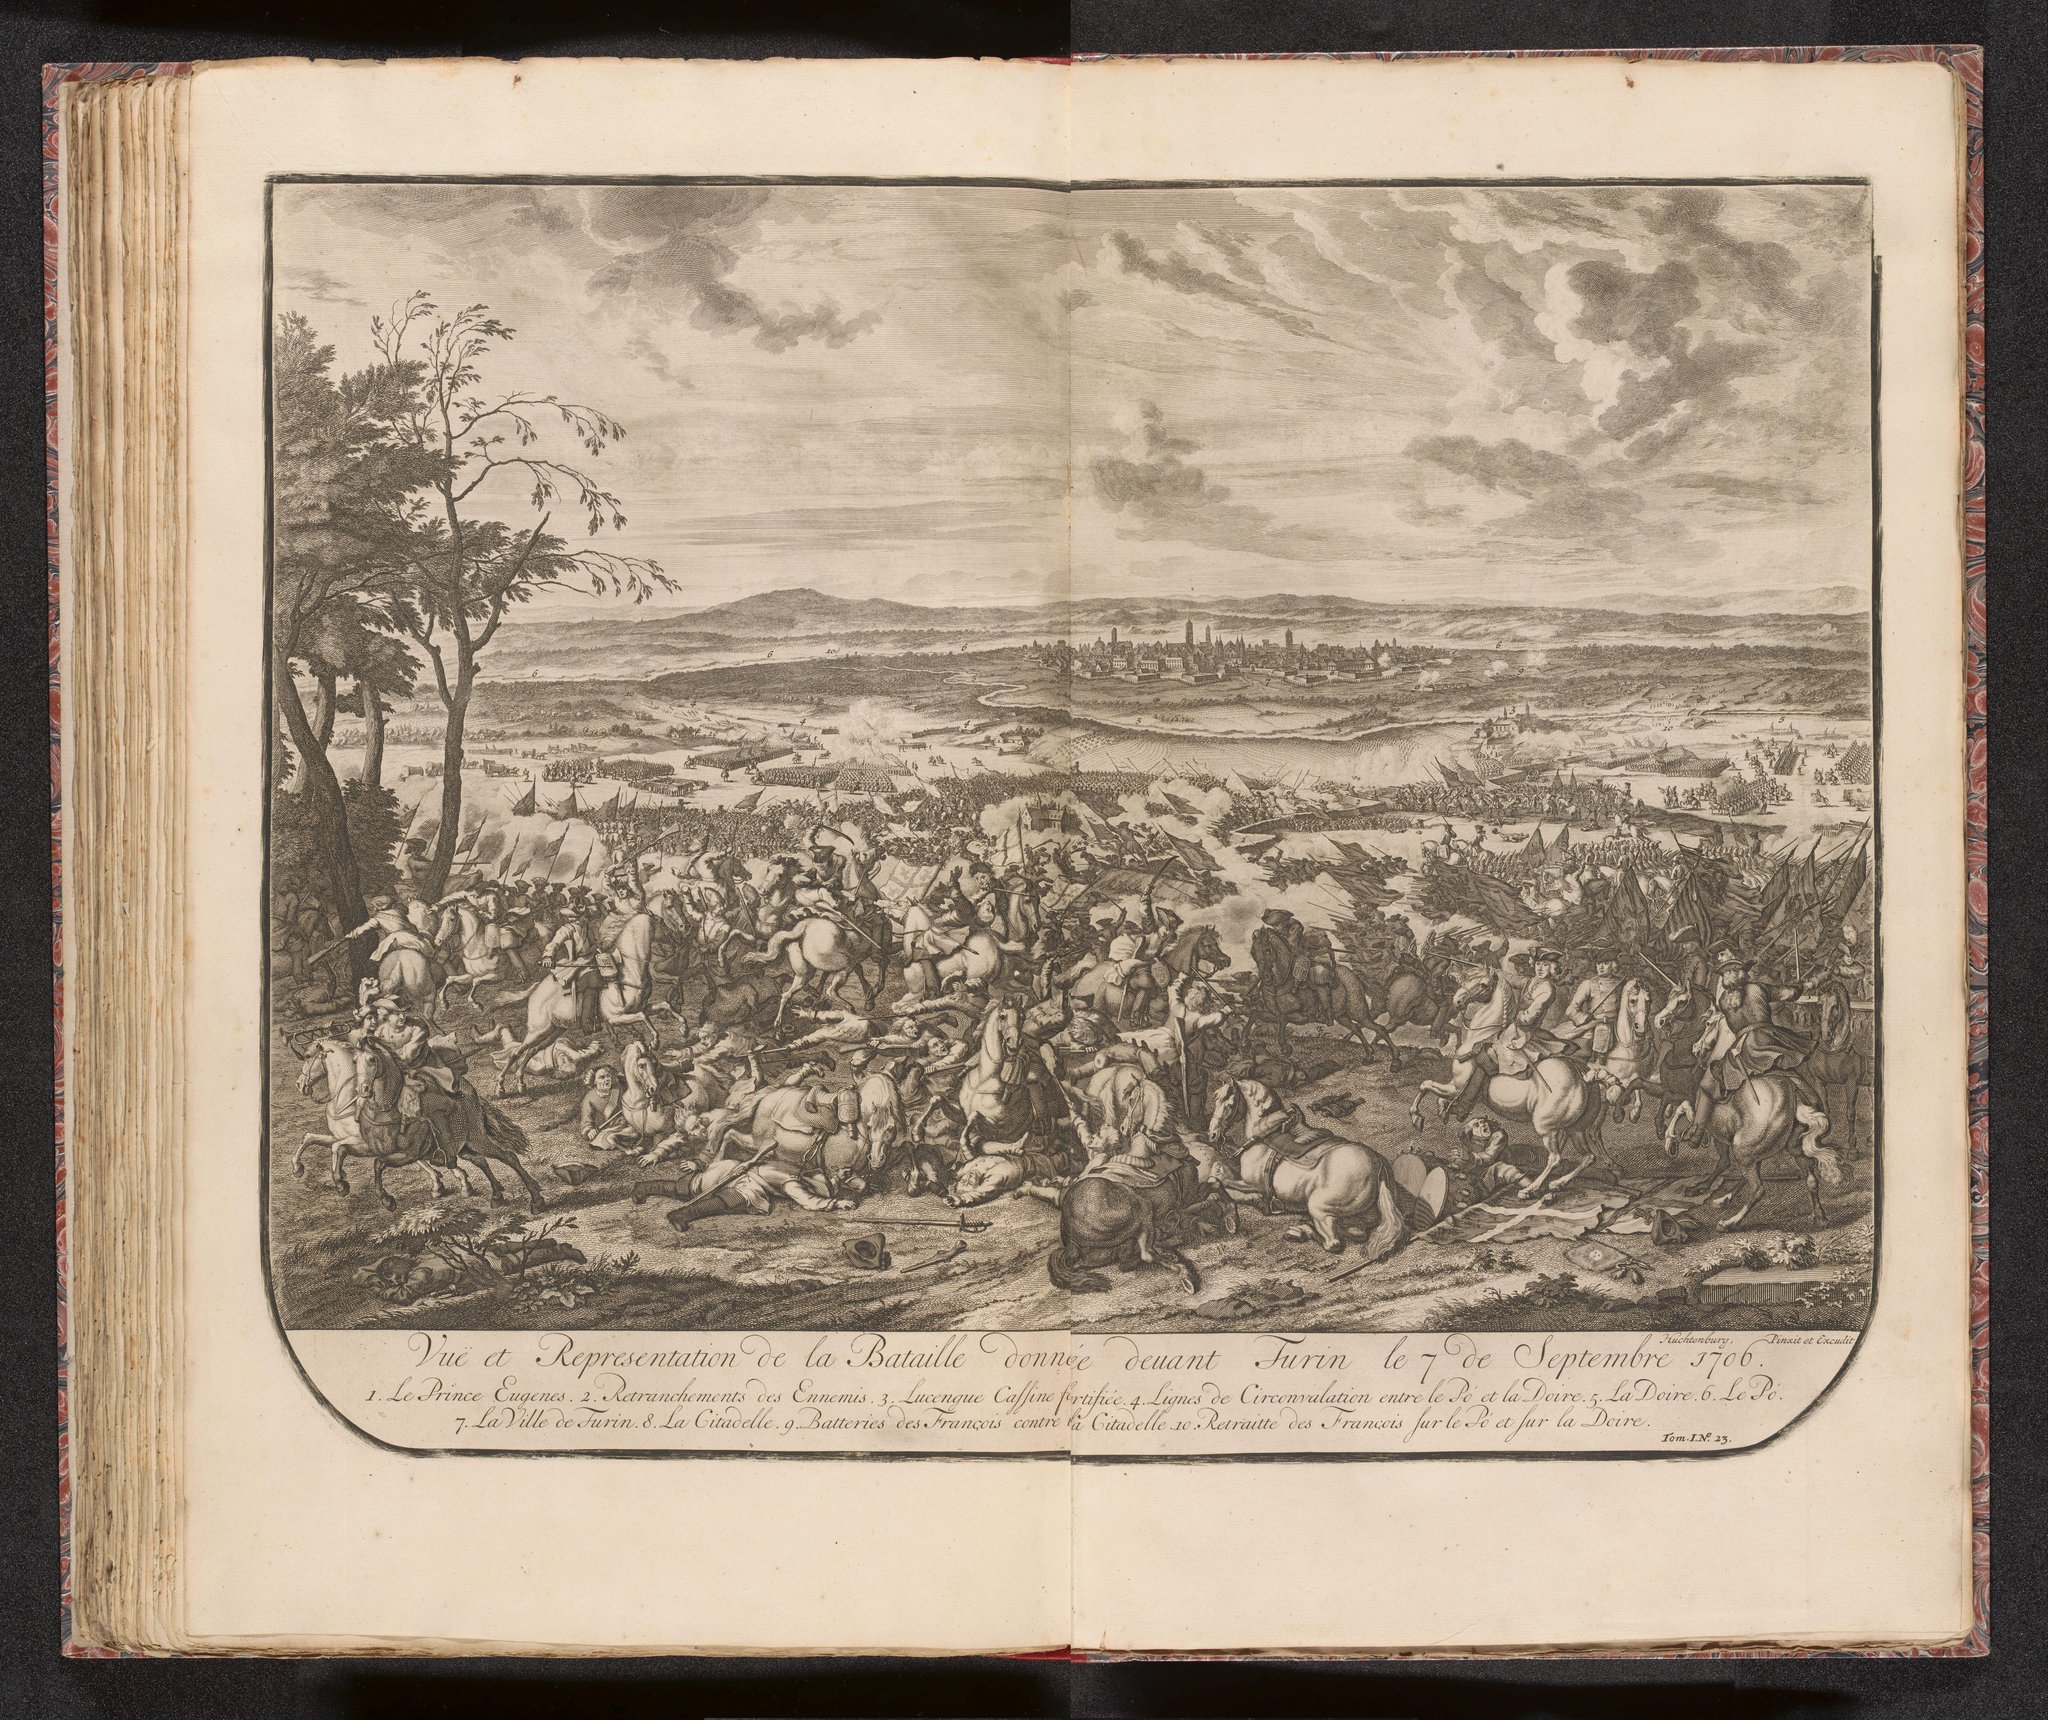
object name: history print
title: Ontzet van Turijn, 1706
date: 1727-1729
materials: paper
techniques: engraving, etching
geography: northern netherlands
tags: paris, vienna, eugenius van savoye, raising the siege with outside assistance, relief, battle (+ land forces)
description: Veldslag bij Turijn, door de Fransen belegerd en ontzet door de Geallieerden onder de prins van Savoye op 7 september 1706. Rechts op de voorgrond de prins te paard. Genummerd rechtsonder: Tom. I. No. 23. Illustratie in het eerste deel van: Jean du Mont, Oorlogskundige beschryving van de veldslagen en belegeringen, der drie ... wydvermaarde krygsoversten... den Prins Eugenius van Savoye, den ... Hertog van Marlborough, en den Prins van Oranje en Nassau-Vriesland, in de editie van 1729. Dit eerste deel is gewijd aan de daden van Eugenius, prins van Savoye.